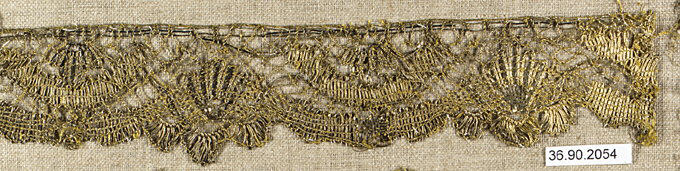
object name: piece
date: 1801-1900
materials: metal thread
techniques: lace